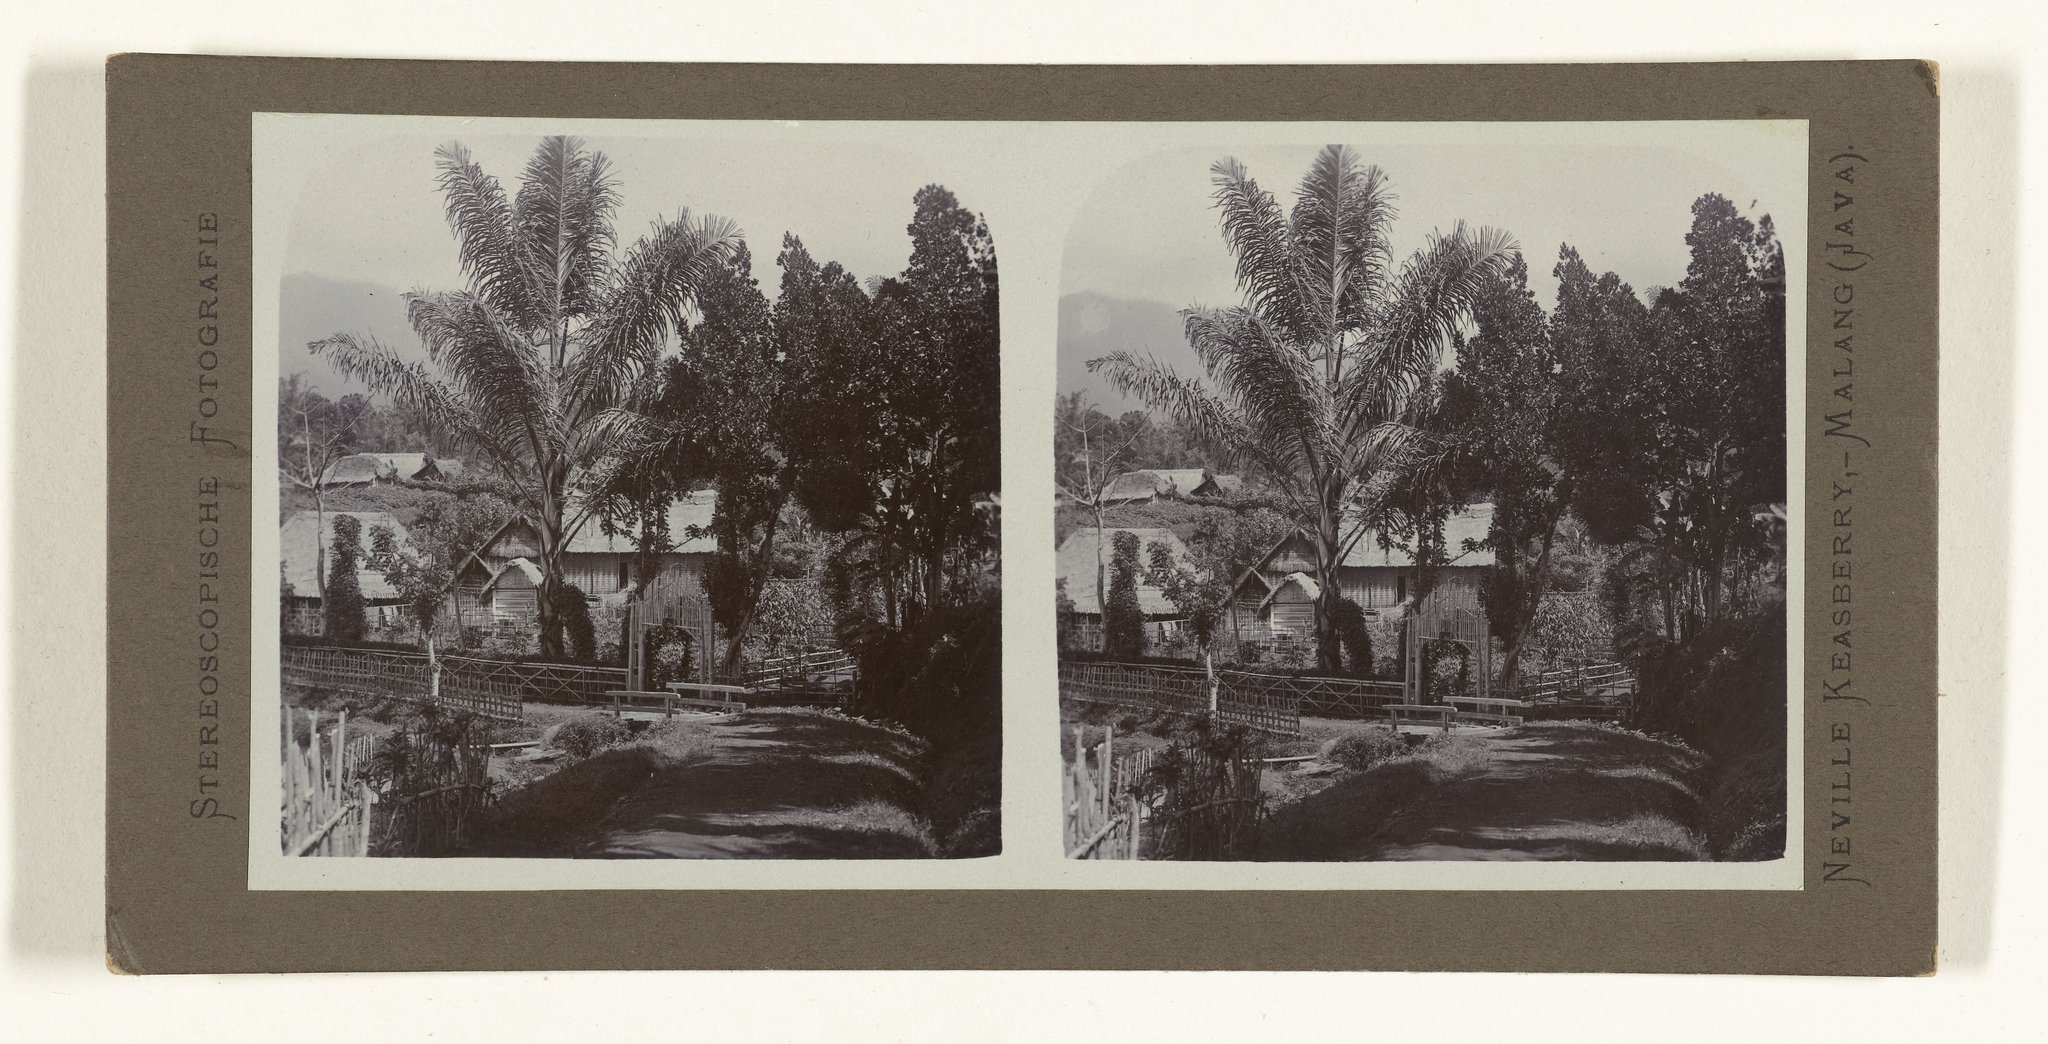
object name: photograph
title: S 2 No 23. Een dessa in 't Gebergte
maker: neville keasberry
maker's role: fotograaf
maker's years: 1866-1944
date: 1900-1935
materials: cardboard, paper, photographic support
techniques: albumen print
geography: malang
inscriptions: inscription: ‘Stereoscopische Fotografie’, signature: ‘Neville Keasberry, Malang (Java)’